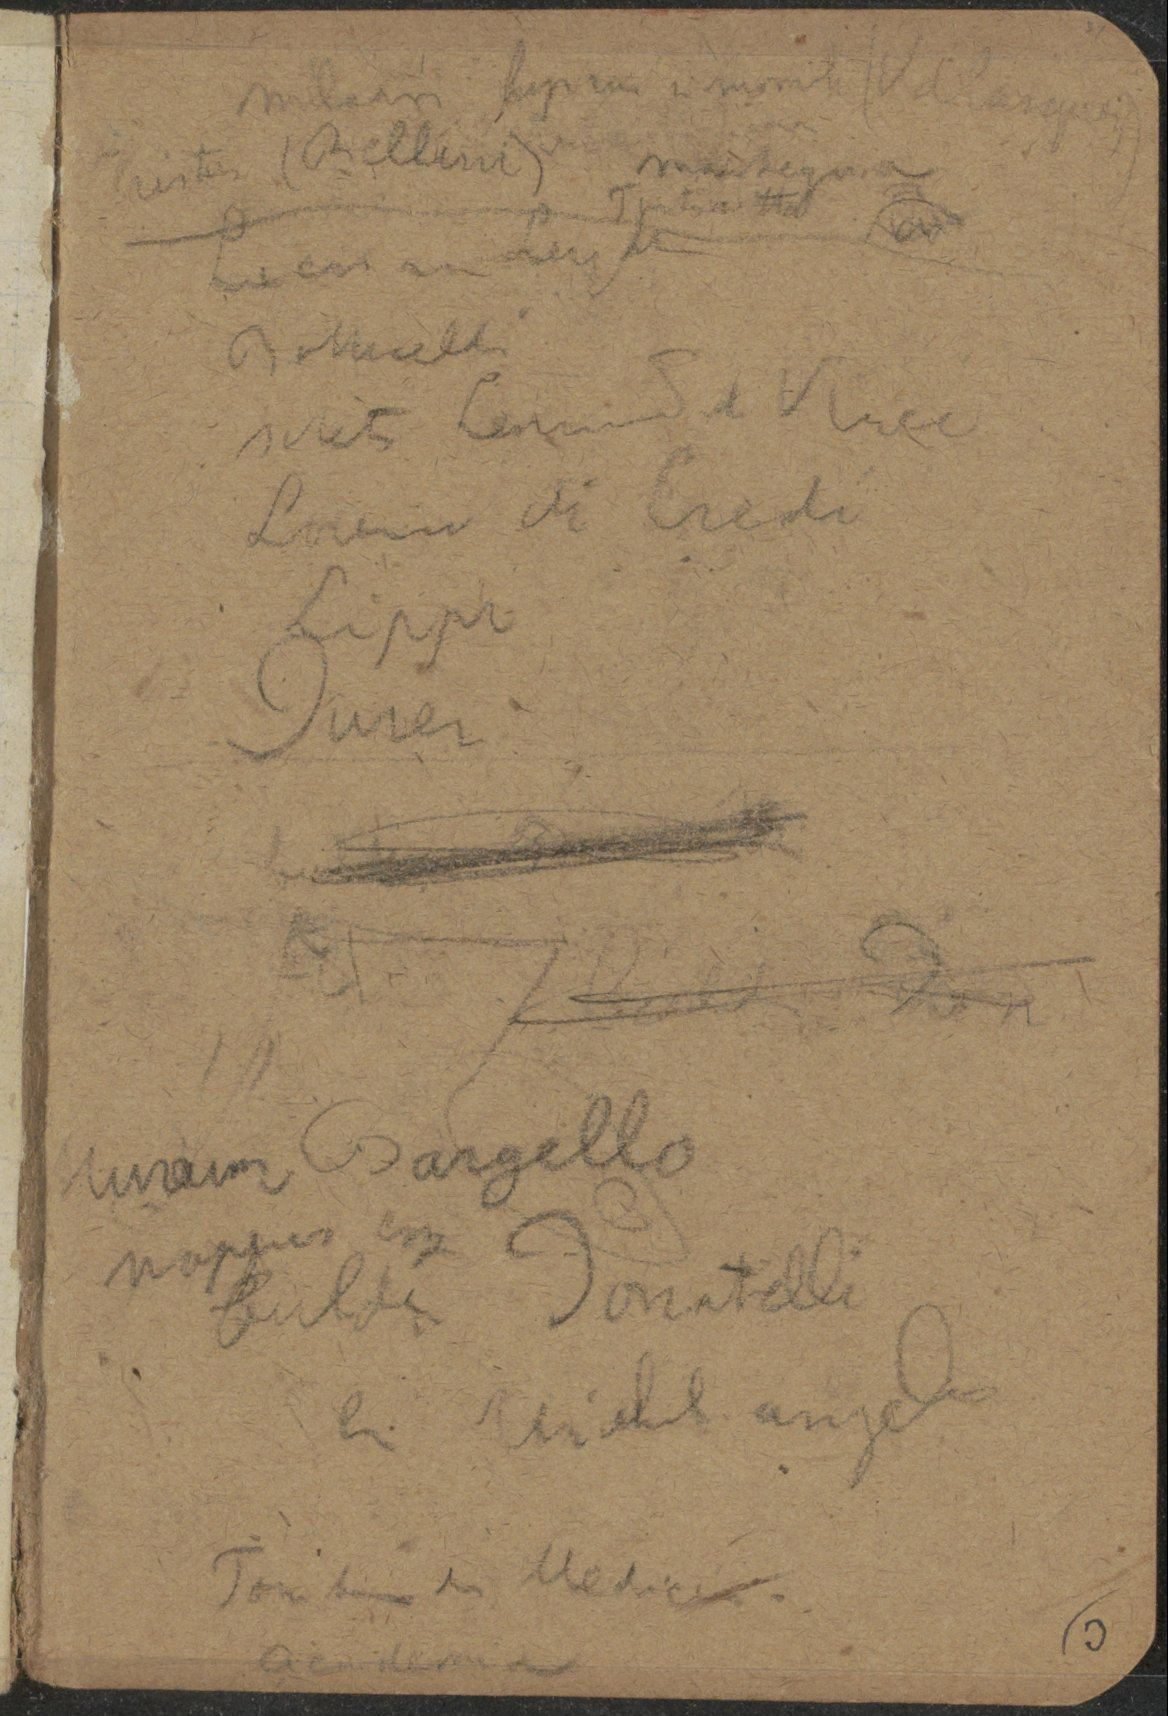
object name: sketchbook leaf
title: Notities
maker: marius bauer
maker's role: draughtsman, print maker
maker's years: 1867-1932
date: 1895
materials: chalk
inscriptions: annotation: ‘[...] (Bellini) mantegna/ [...]/ Lucas van Leyden/ Botticelli/ [...]/ Lorenzo di Credi/ Lippi/ Durer/ [...] Bargello [...]’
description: Achterste schutblad uit een schetsboek met 28 bladen.